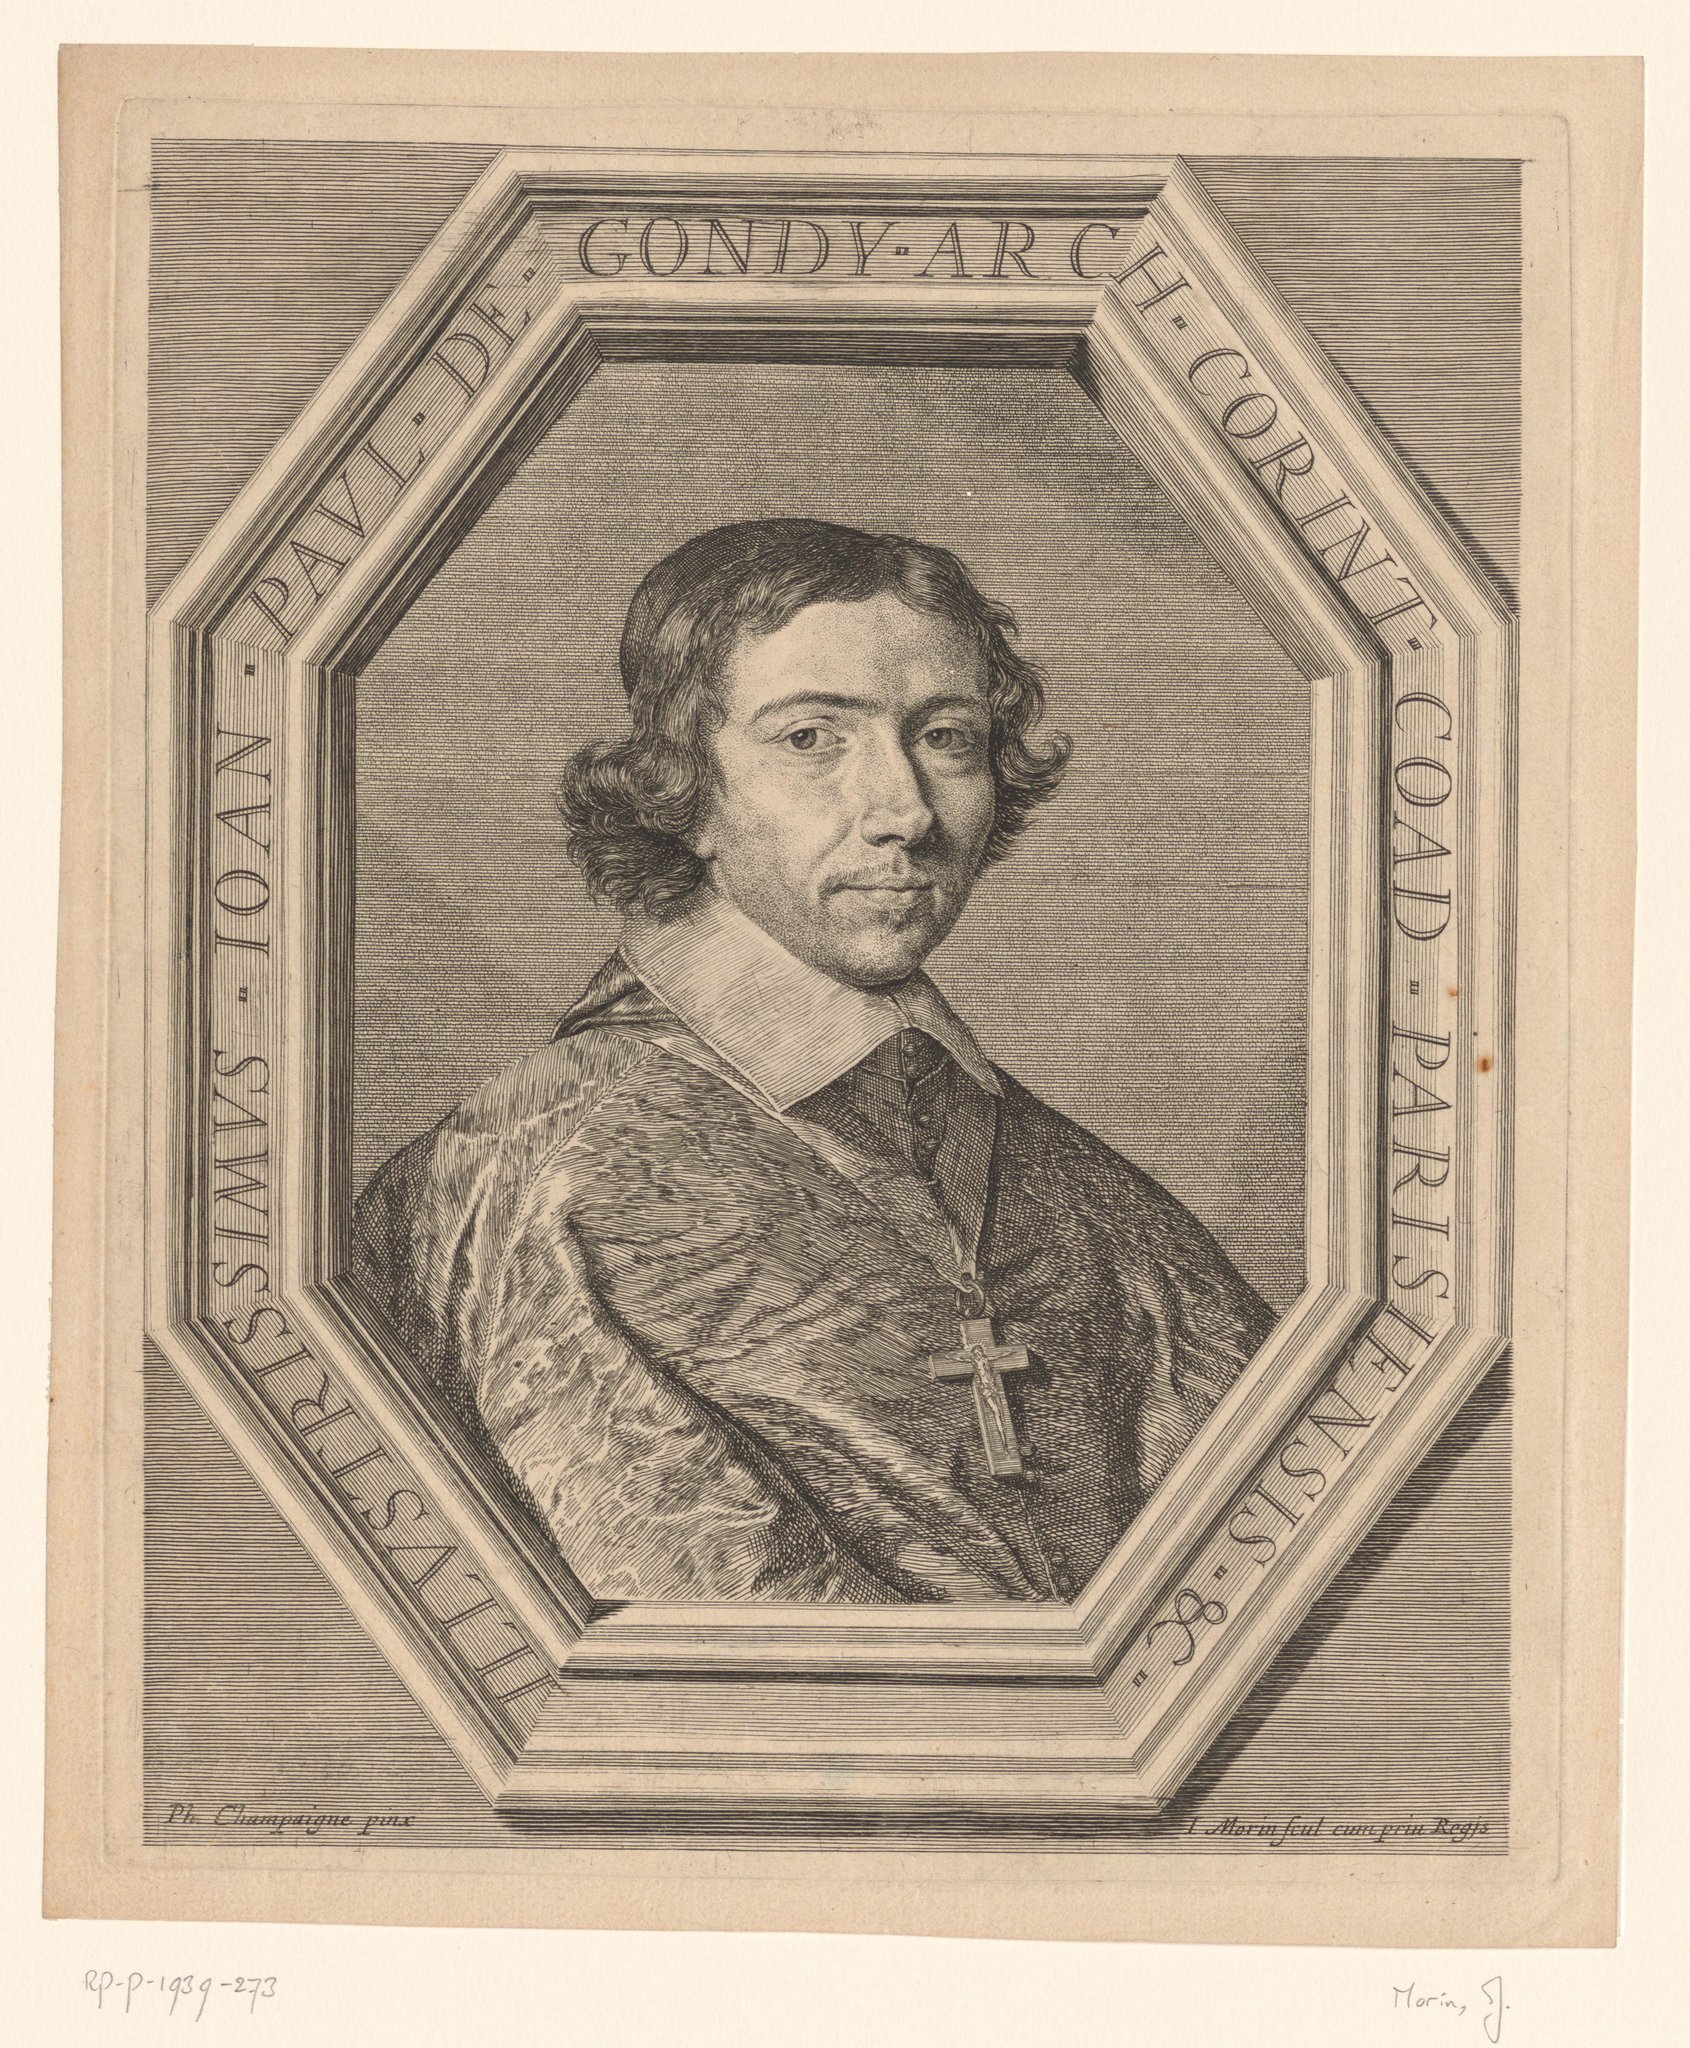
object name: print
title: Portret van Jean-François Paul de Gondi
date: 1644-1650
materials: paper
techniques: engraving, etching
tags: paris, historical persons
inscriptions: collector's mark: Lugt 2228, collector's mark: Lugt 2760